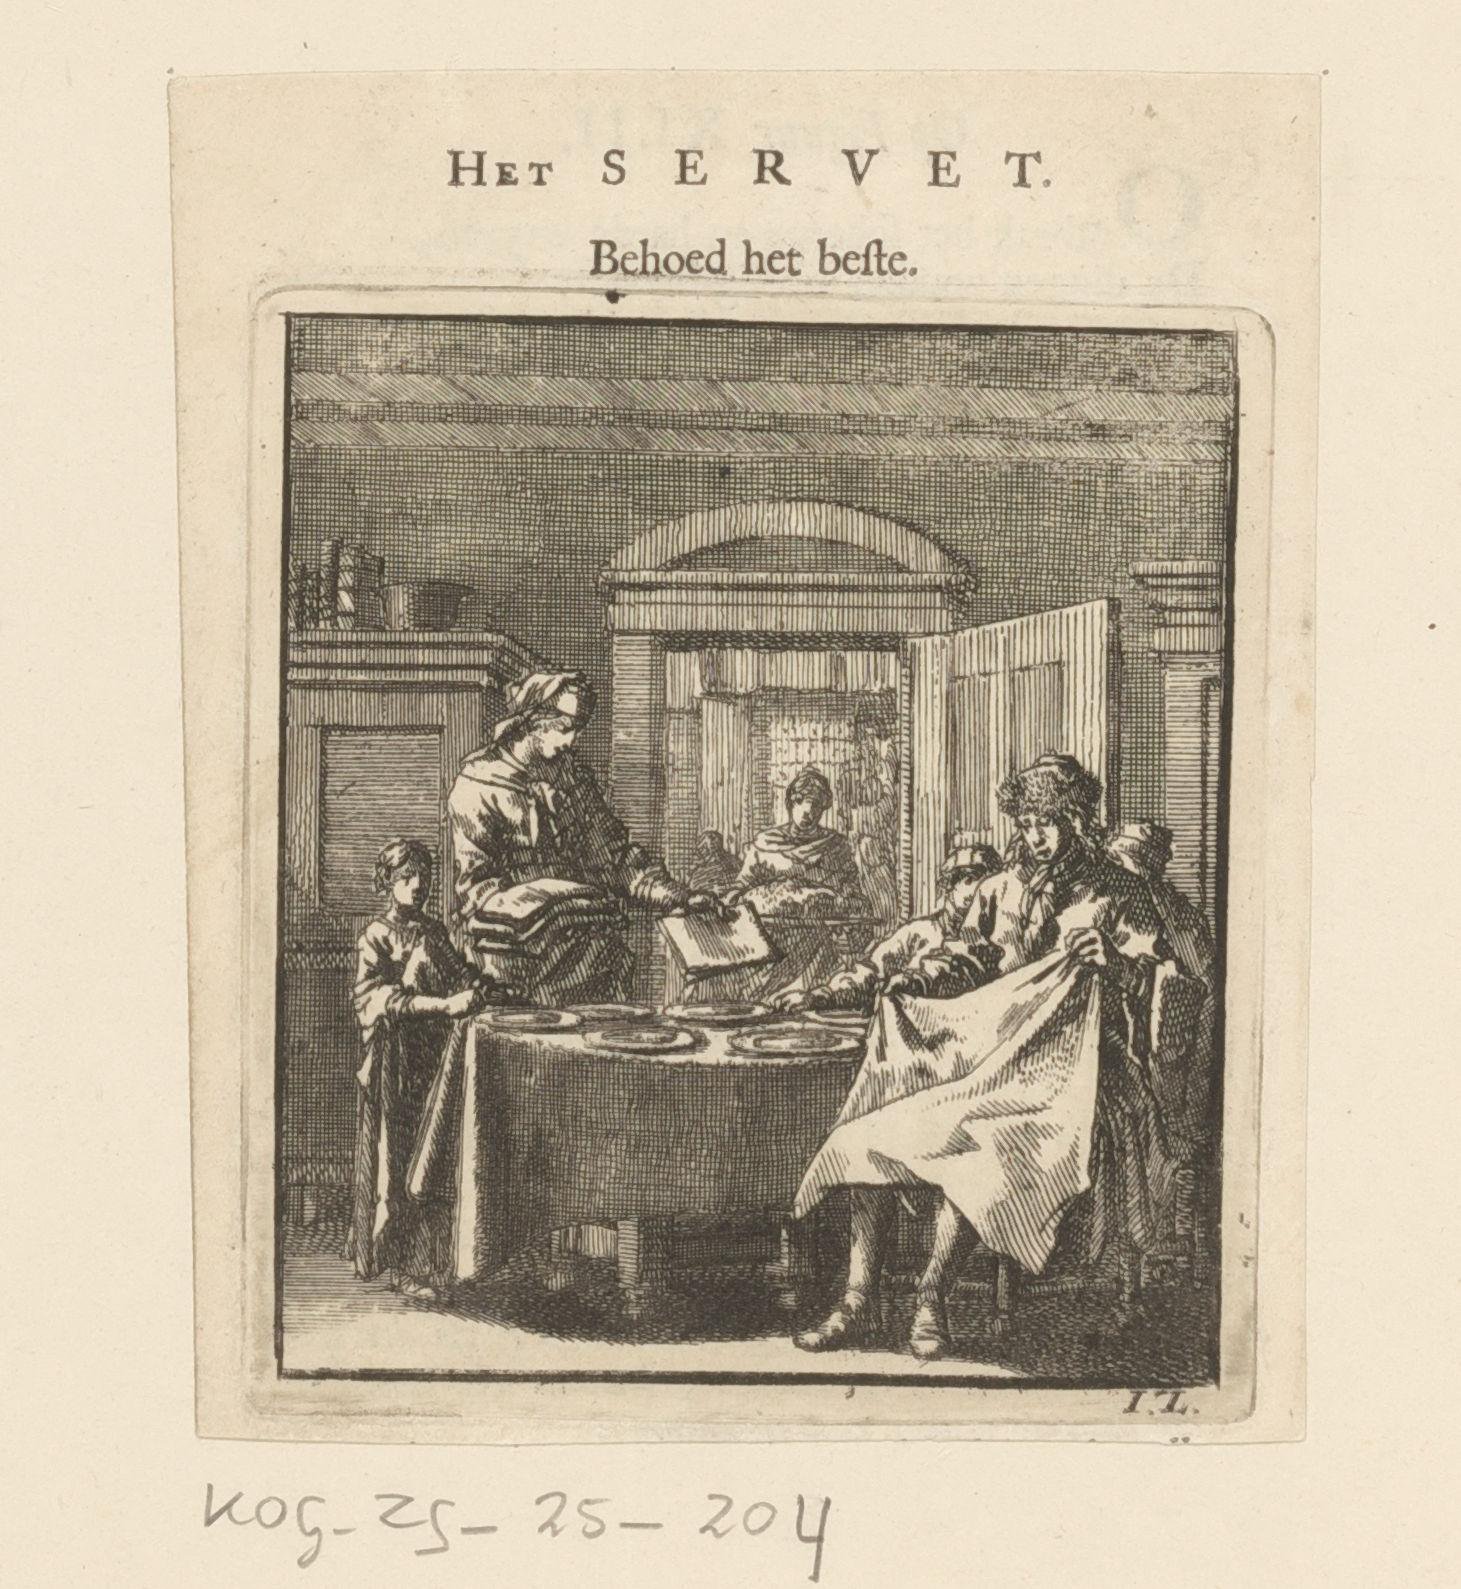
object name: print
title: Vrouw deelt servetten uit terwijl een man de zijne ontvouwt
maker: jan luyken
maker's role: draughtsman, print maker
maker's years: 1649-1712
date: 1711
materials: paper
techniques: etching, letterpress printing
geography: amsterdam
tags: napkin, waiting at table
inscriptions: stamp, collector's mark: Lugt 1641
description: Prent uit: Luyken, Jan. Het leerzaam huisraad, vertoond in vyftig konstige figuuren, met godlyke spreuken en stichtelyke verzen. Amsterdam: weduwe Pieter Arentsz. II en Cornelis van der Sys,, 1711, p. 150.